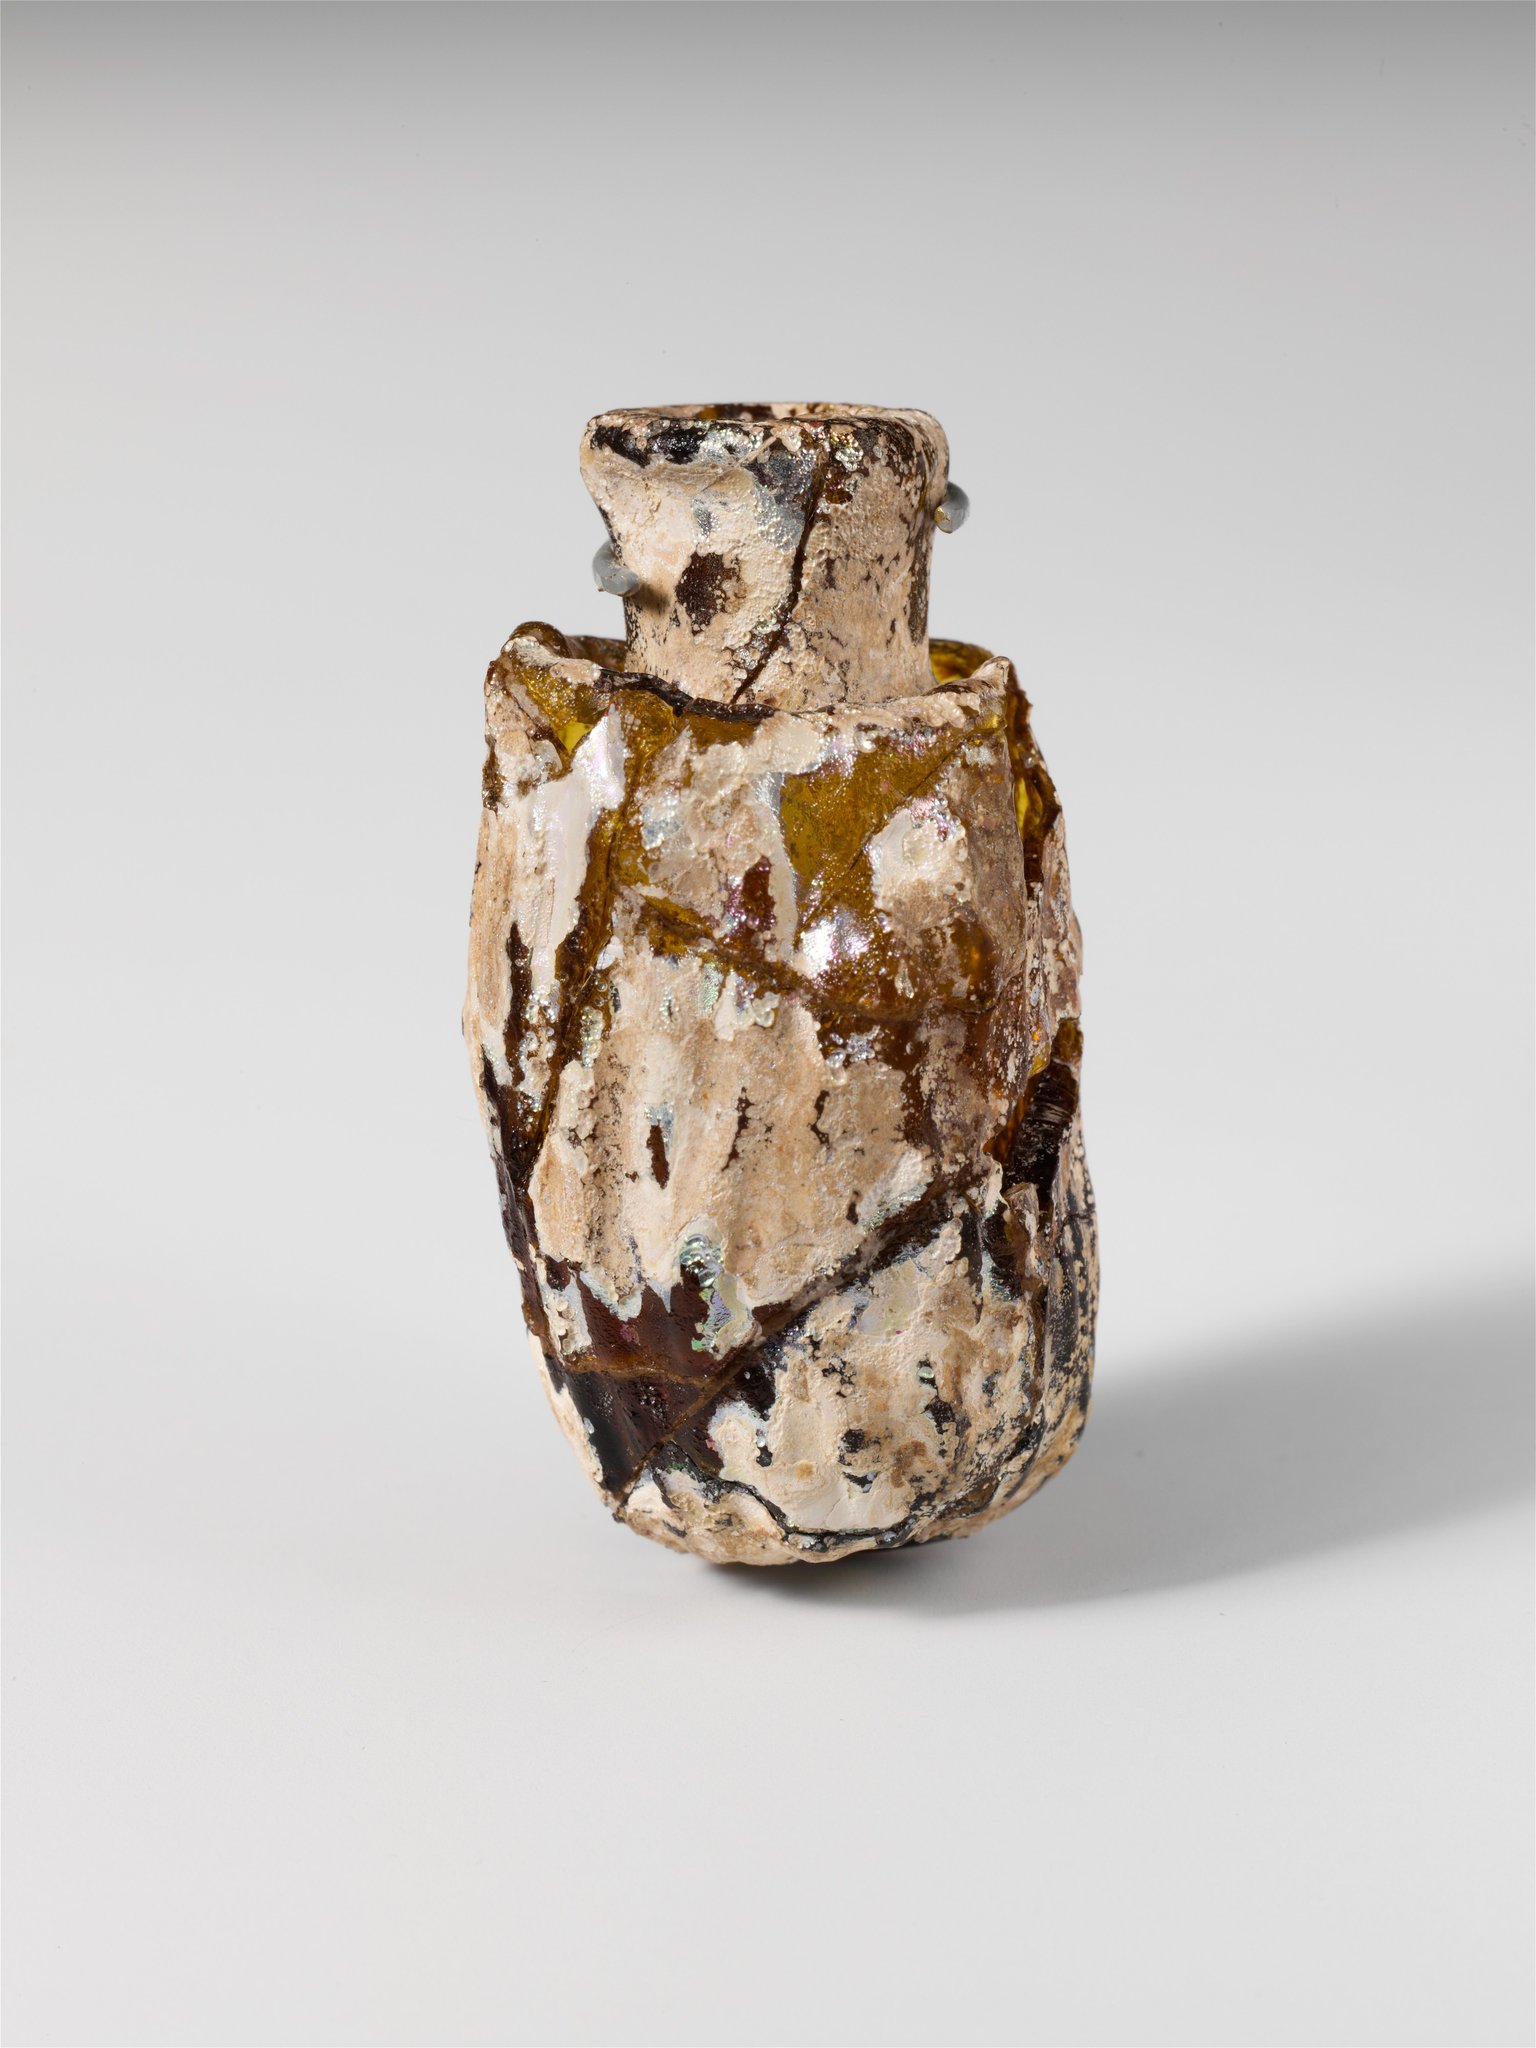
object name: flask in the form of a date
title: Glass bottle shaped like a date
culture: roman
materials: glass